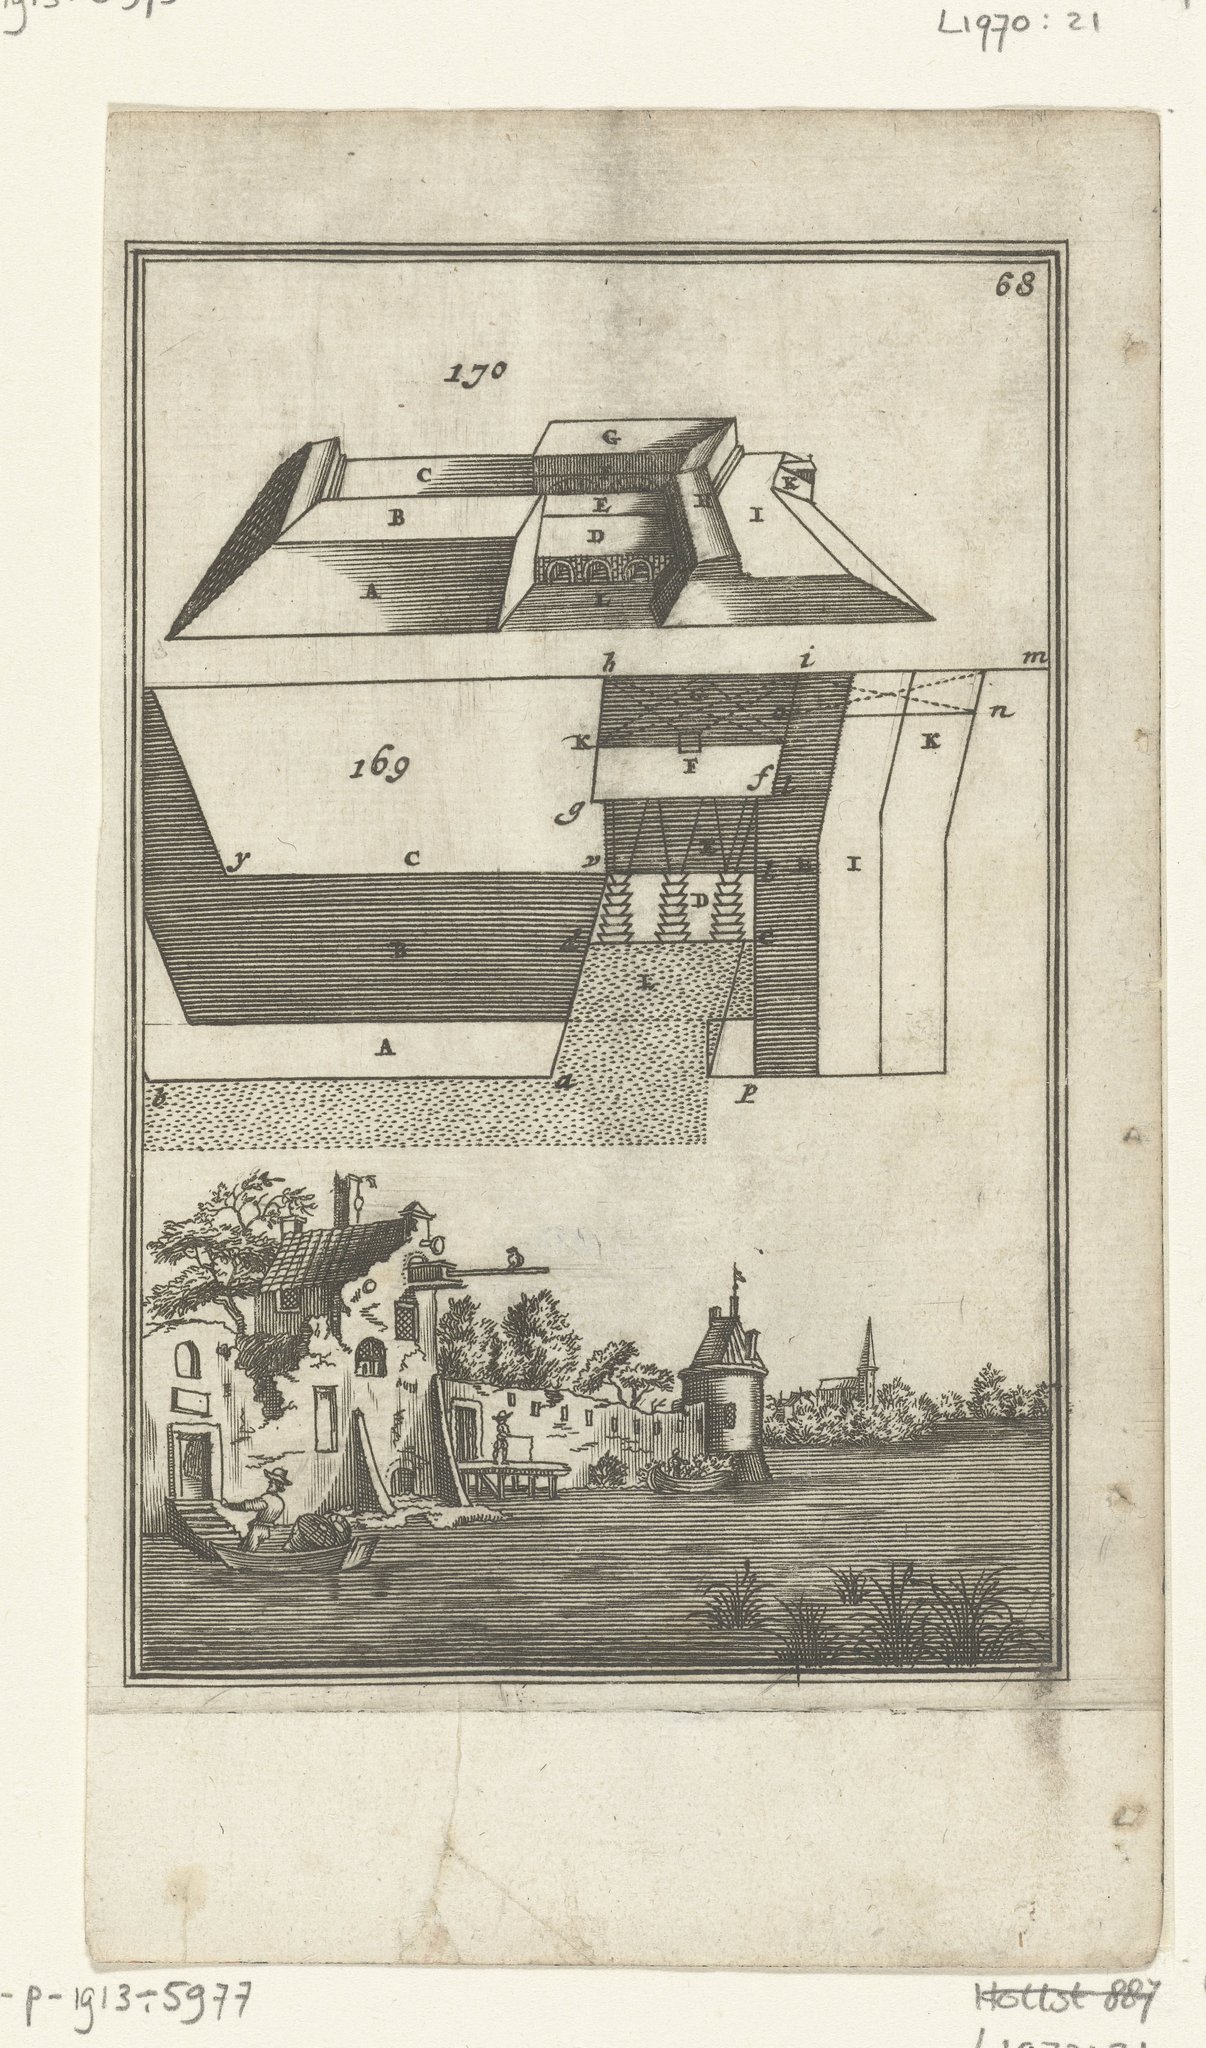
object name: book illustration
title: Illustratie voor 'Den Arbeid van Mars' van Allain Manesson Mallet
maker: romeyn de hooghe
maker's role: draughtsman, goldsmith, painter, print maker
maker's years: 1645-1708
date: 1672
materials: paper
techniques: engraving, etching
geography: amsterdam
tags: landscapes with waters, waterscapes, seascapes (in the temperate zone), fortifications, military engineering, city-walls, mathematics, village-walls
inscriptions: collector's mark: Lugt 2228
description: Schematische weergaven van kazematten. Daaronder een gezicht op de muur van een stad of dorp aan een water. In de hoek rechtsboven het cijfer 68 (= het nummer van de pagina in het boek waartegenover de illustratie geplaatst is).